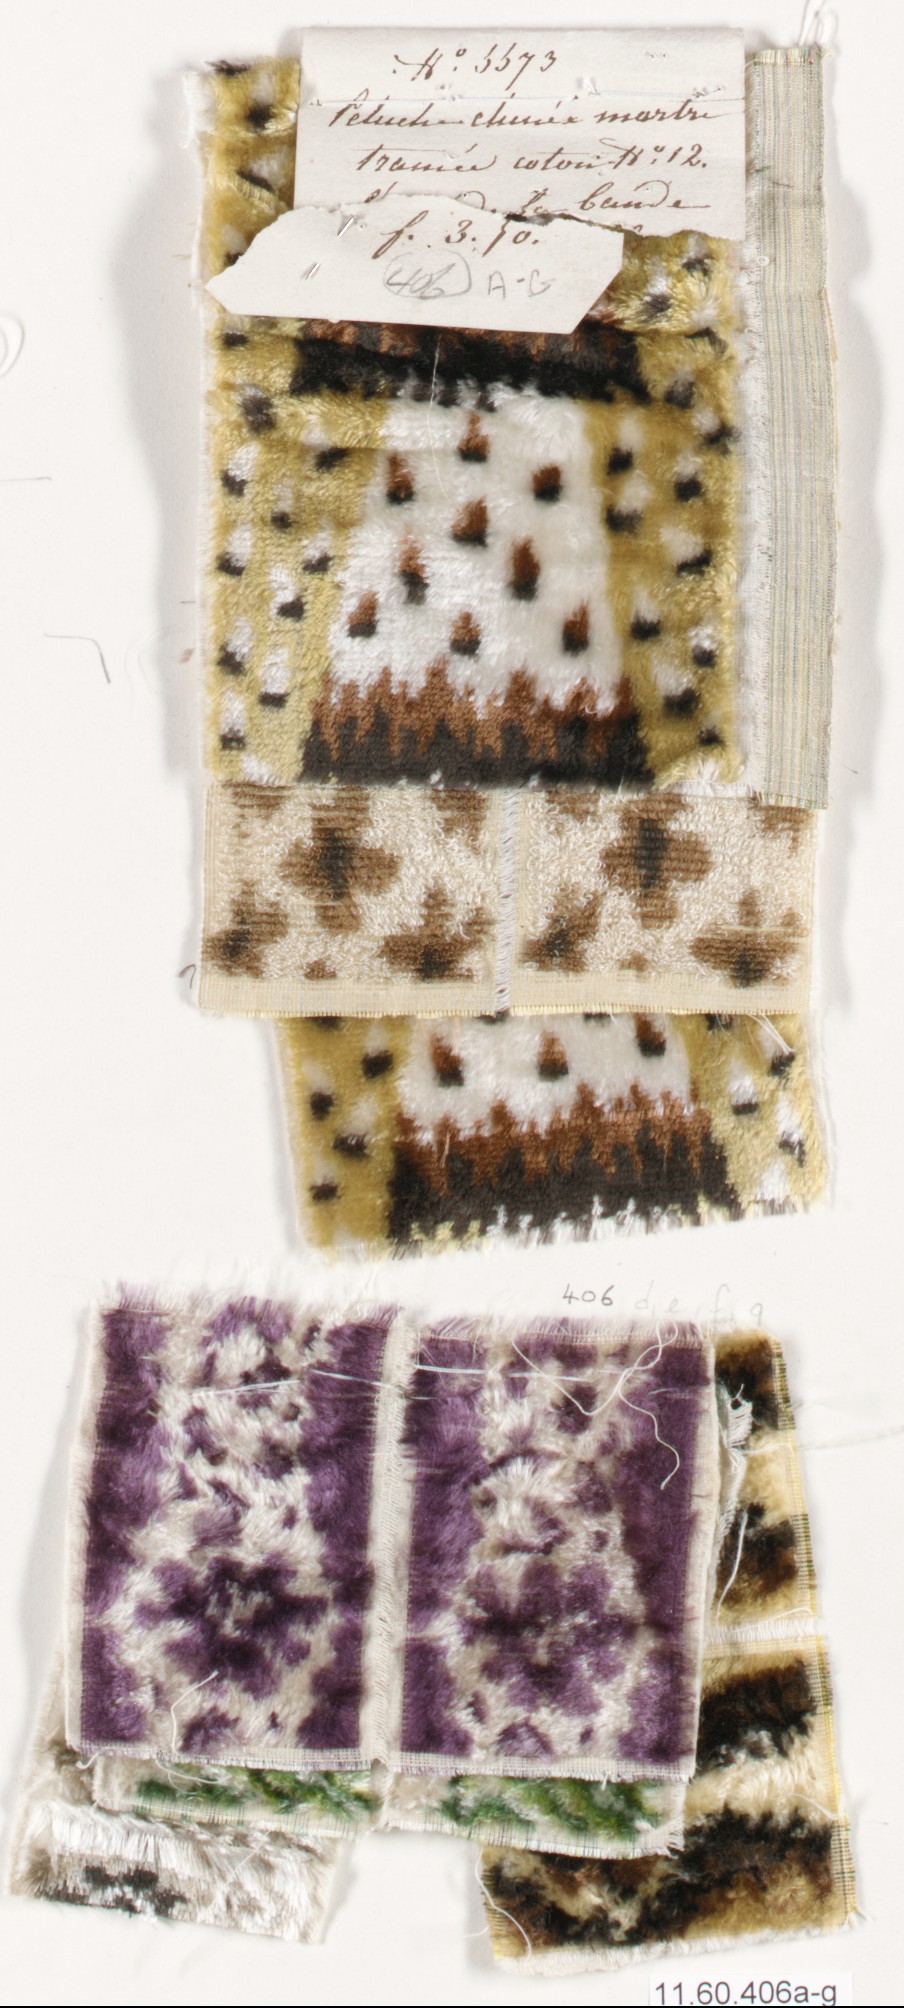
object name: fragment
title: Fragments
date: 1801-1900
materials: velvet